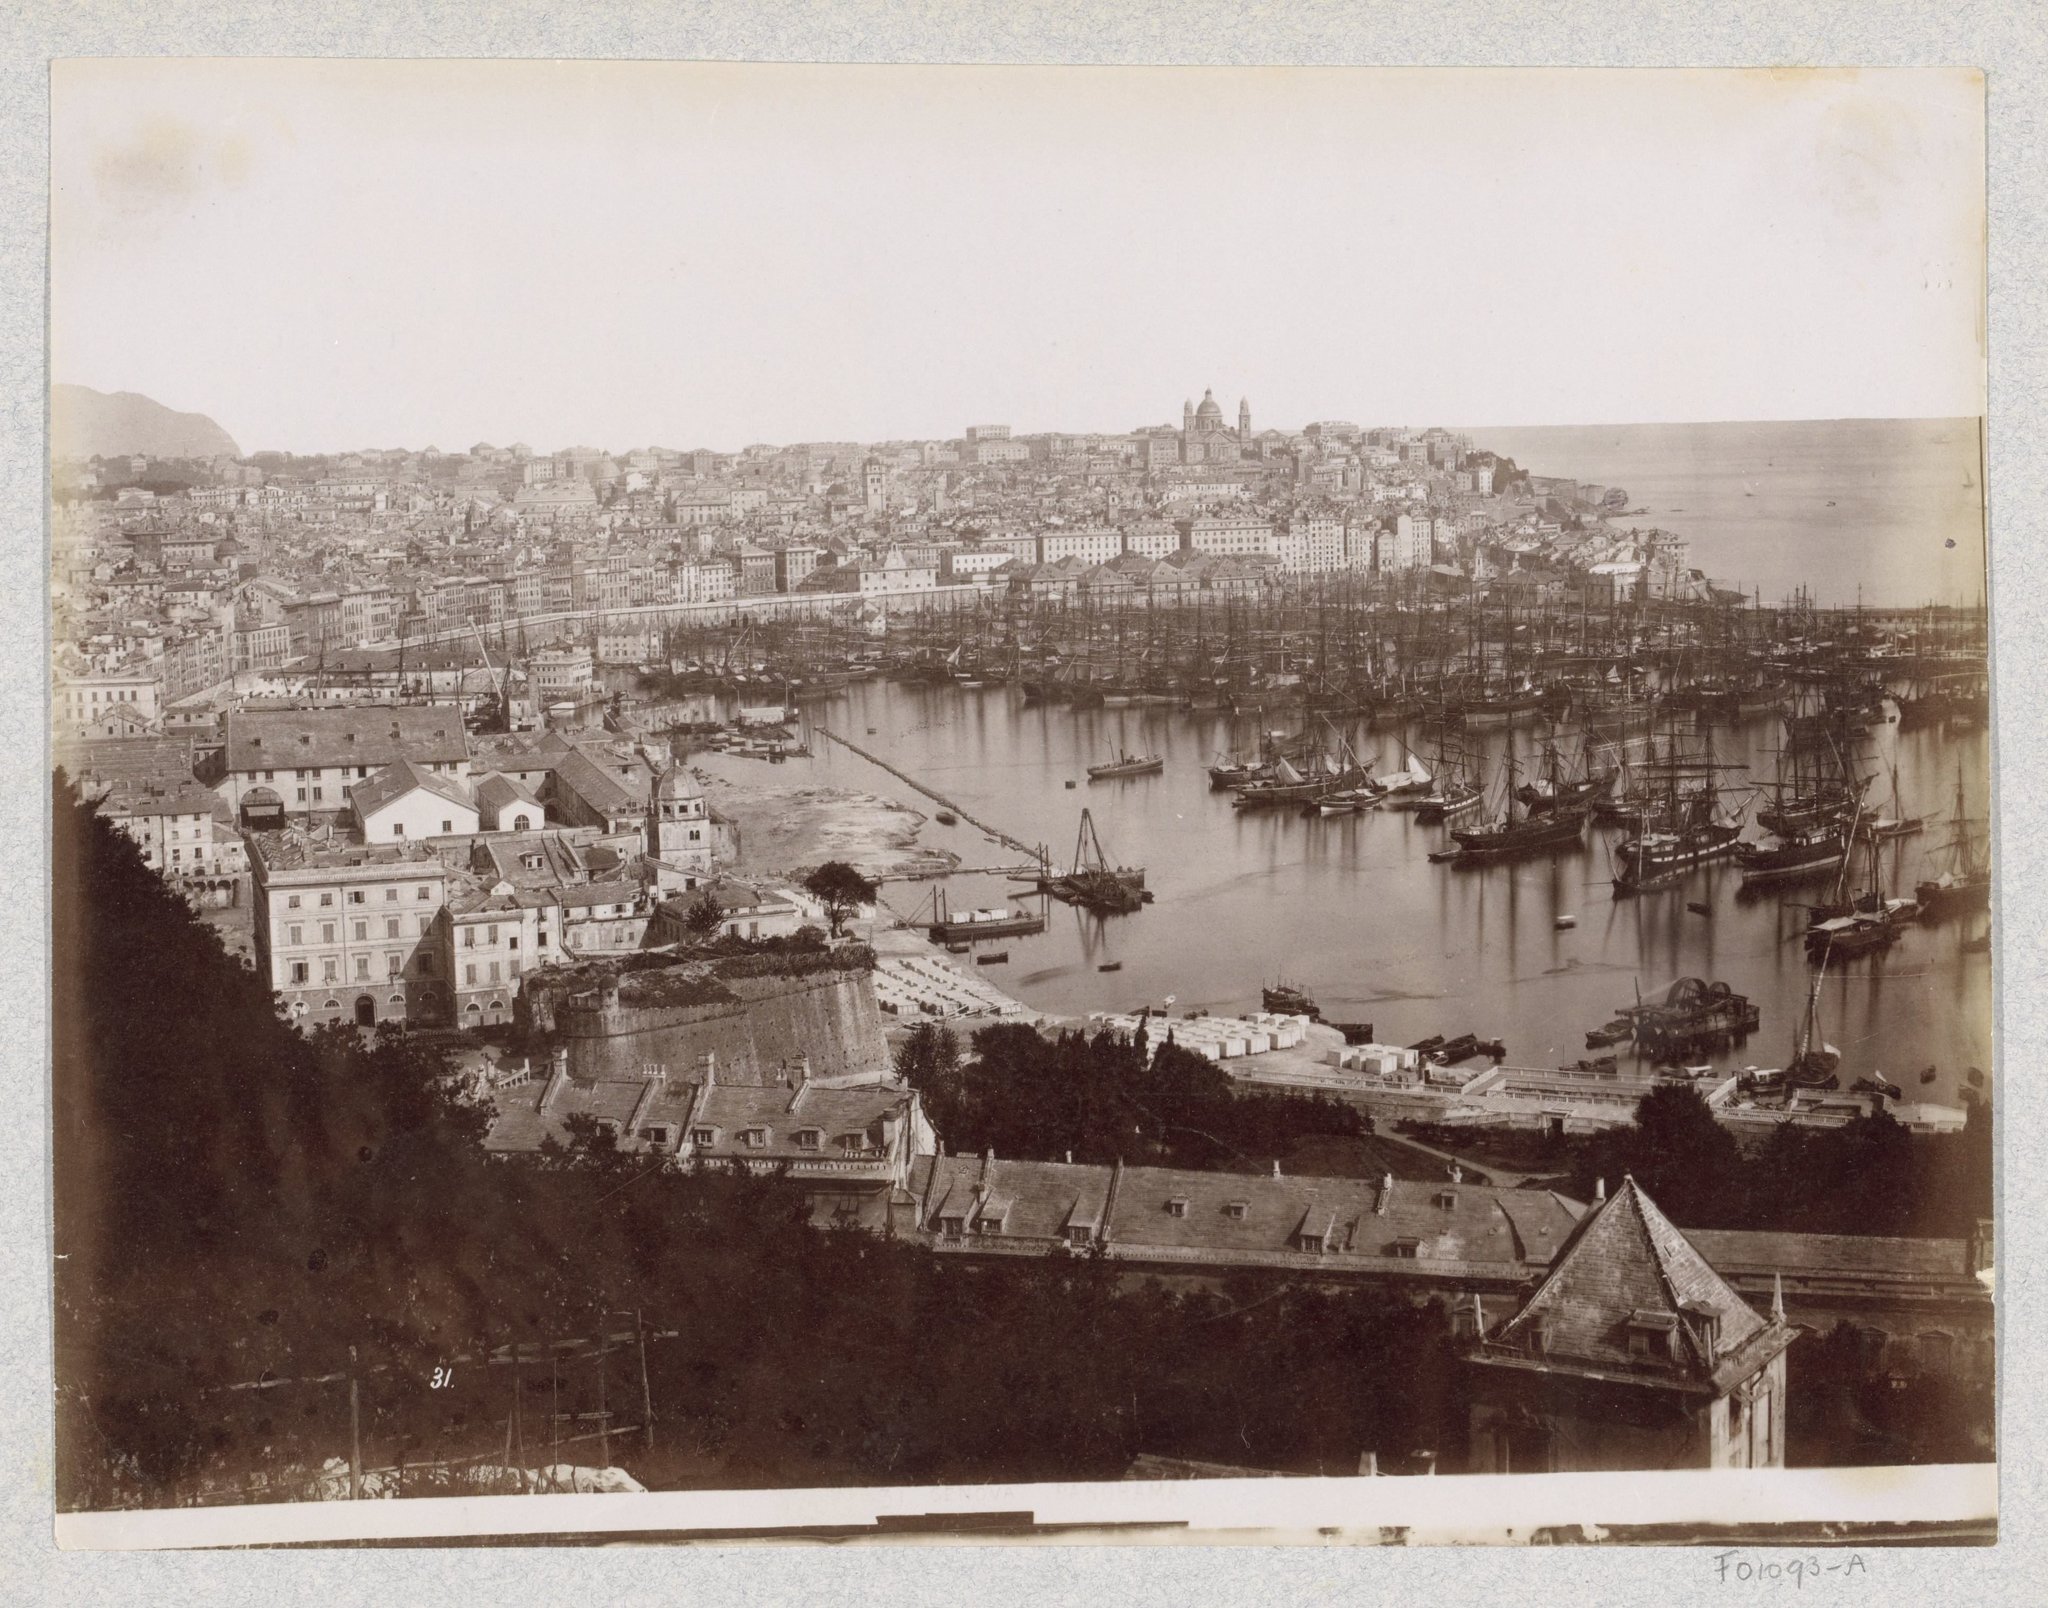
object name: photograph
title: Gezicht op de haven van Genua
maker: alfredo noack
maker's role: fotograaf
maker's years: 1833-1895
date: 1870-1890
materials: paper, photographic support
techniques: albumen print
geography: genoa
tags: harbour (+ view ~ vehicle, ship, etc.), prospect of city, town panorama, silhouette of city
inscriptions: negative number: ‘31’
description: Onderdeel van Reisalbum met foto's van bezienswaardigheden in Genua, Florence en Venetië.